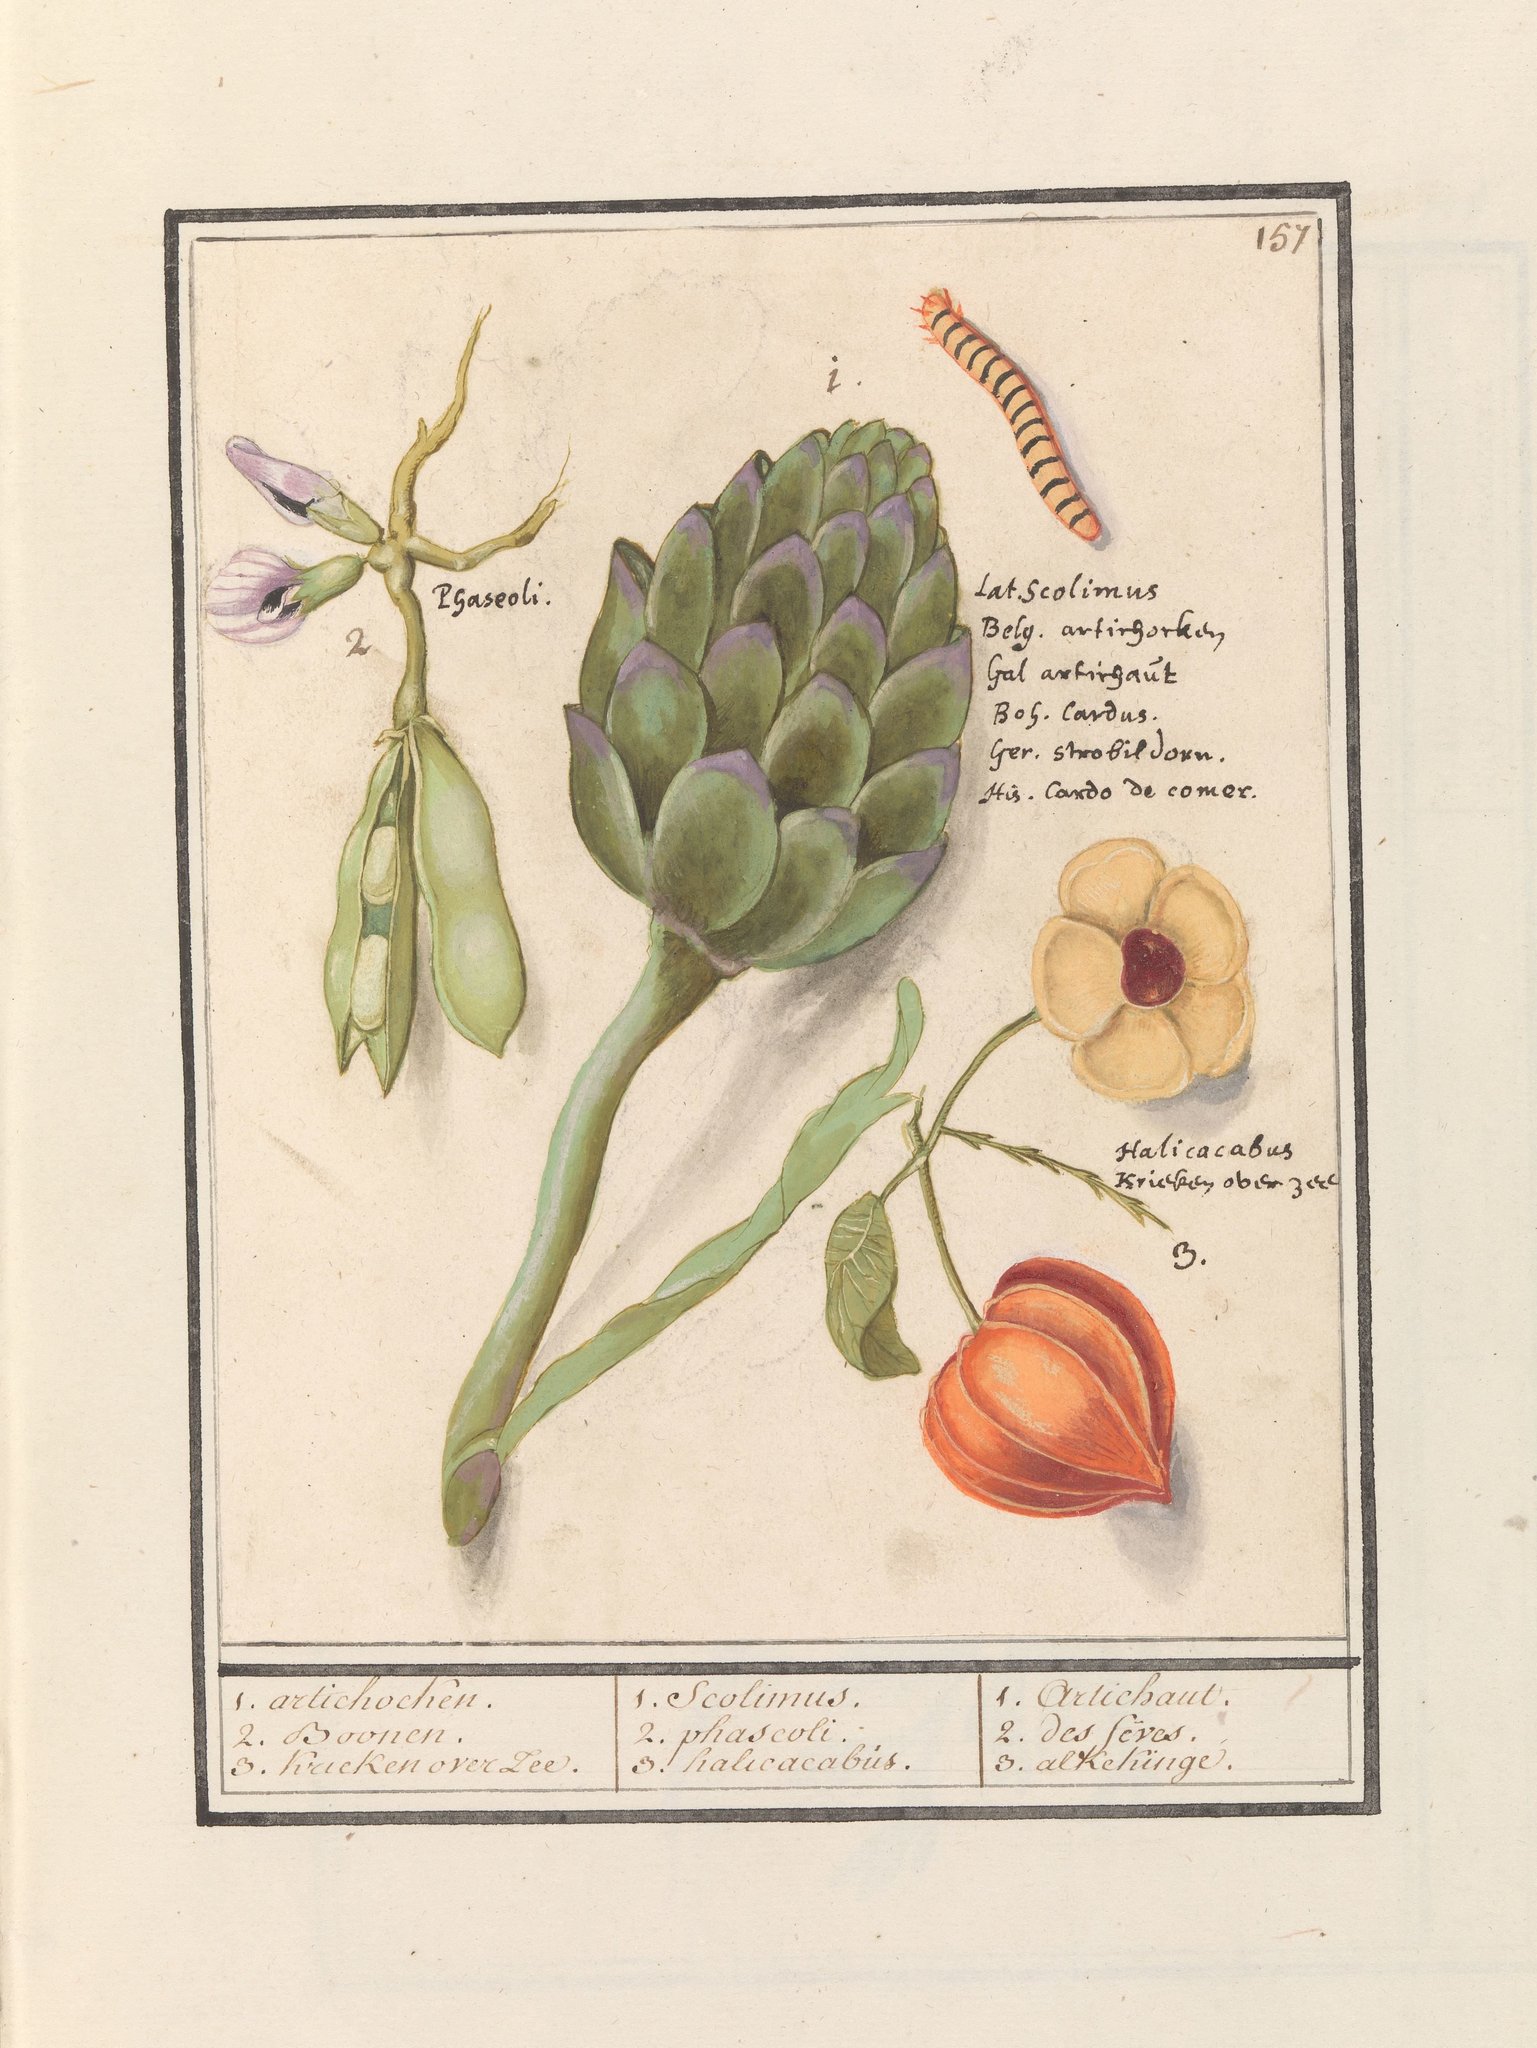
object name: drawing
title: 1. artichocken. 2. Boonen. 3. Krieken over Zee. / 1. Scolimus. 2. phascoli. 3. halicacabus. / 1. Artichaut. 2. des feves. 3. alkekinge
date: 1596-1610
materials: chalk, paint, ink, paper, watercolor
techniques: brush, pen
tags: flowers: physalis, insects: caterpillar, plants and herbs: bean, fruits: beans, plants and herbs: artichoke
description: Bonen (waarschijnlijk tuinbonen), een artisjok en de bloem en vrucht van de lampionplant (goudbes of Kaapse kruisbes). Bovenaan ook een rups. Rechtsboven genummerd: 157. Met de namen in verschillende talen. Onderdeel van het tweede album met tekeningen van bloemen en planten. Negende van twaalf albums met tekeningen van dieren, vogels en planten bekend rond 1600, gemaakt in opdracht van keizer Rudolf II. Met toelichting in Nederlands, Latijn en Frans.